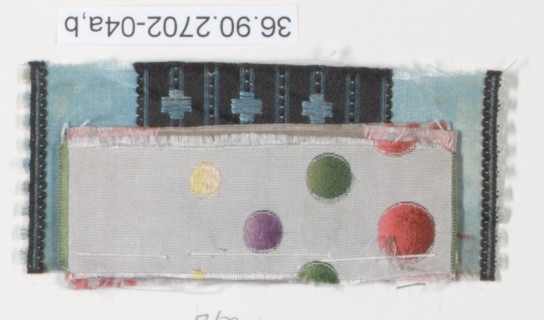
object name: ribbon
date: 1801-1900